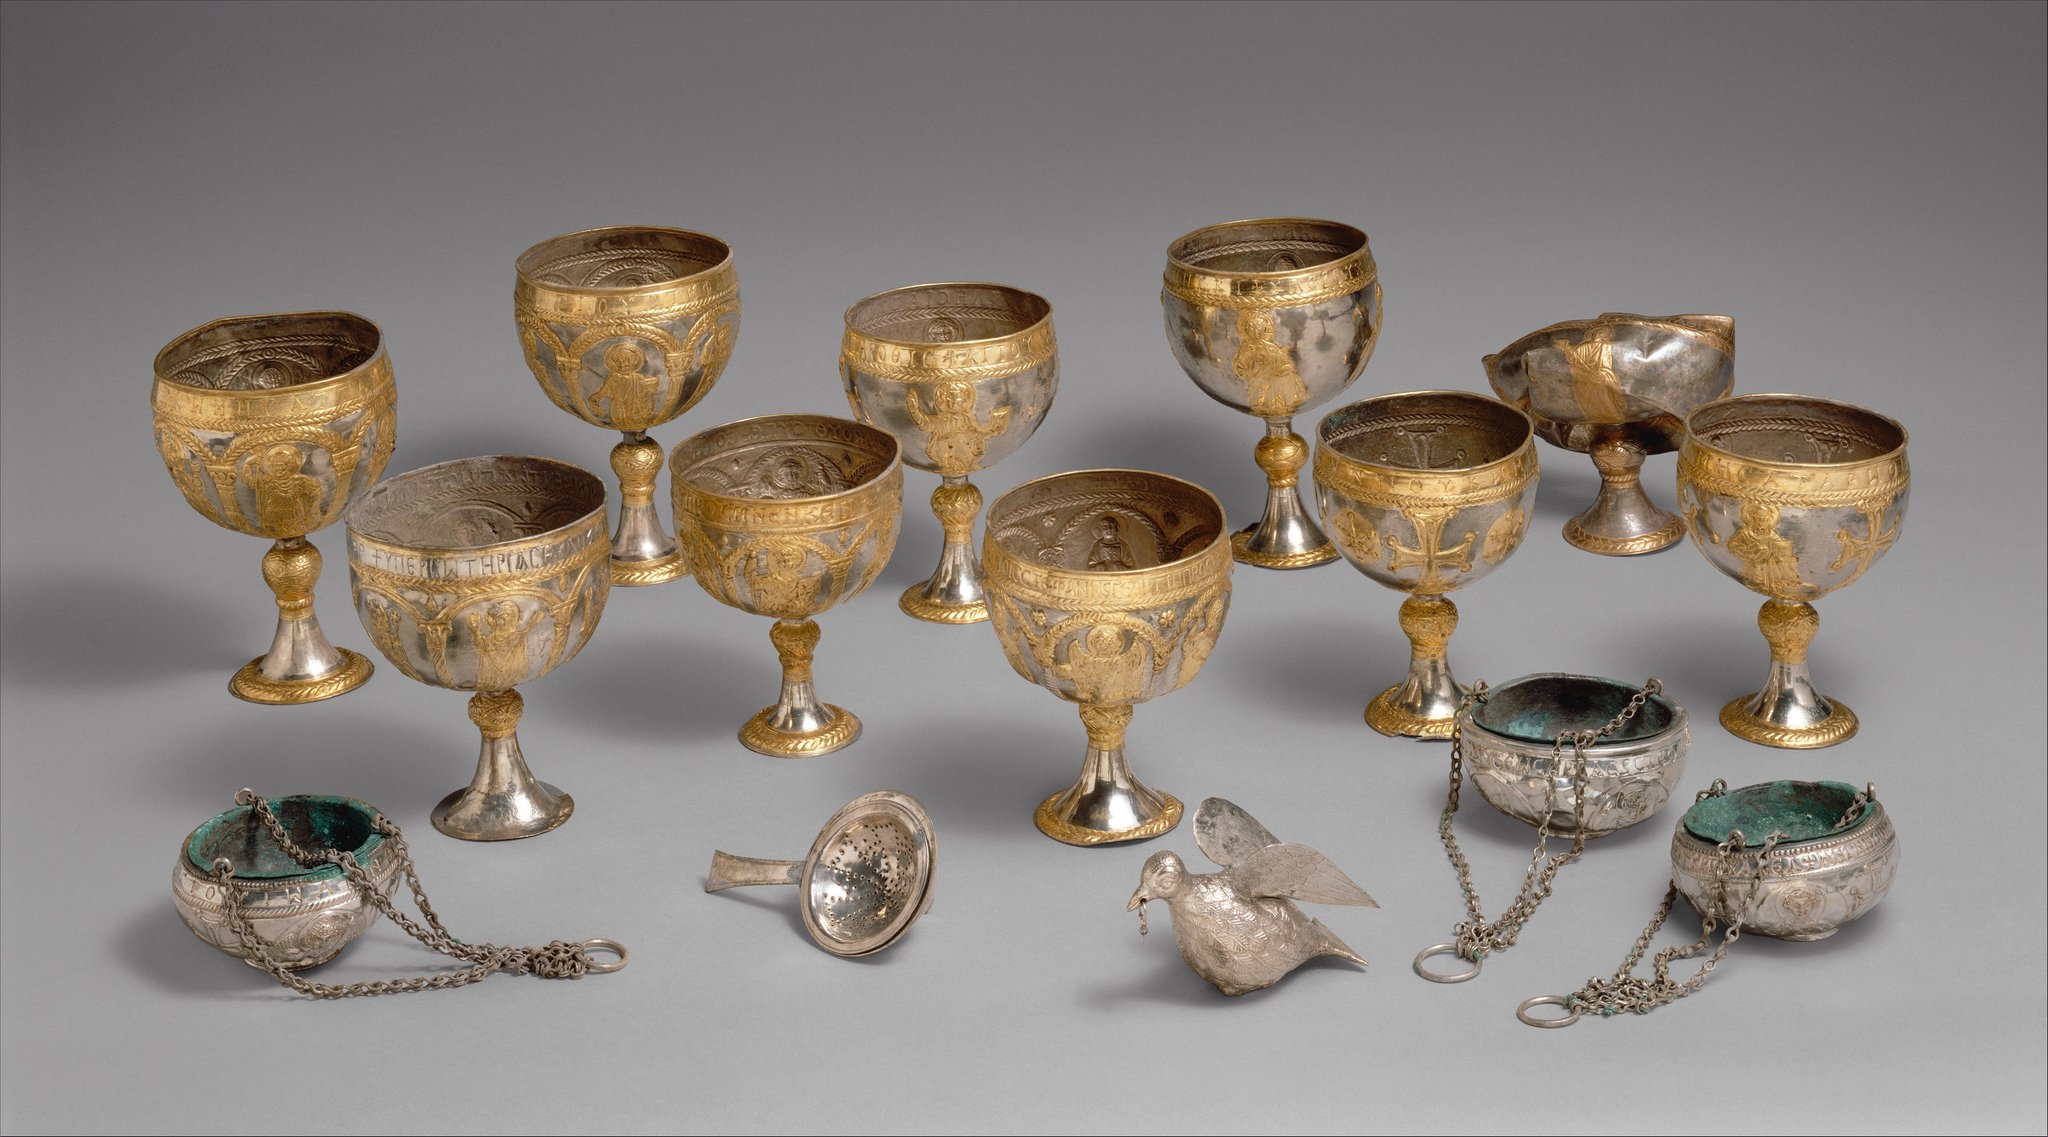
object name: liturgical object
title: The Attarouthi Treasure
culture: byzantine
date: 500-650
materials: silver, silver gilt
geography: syria